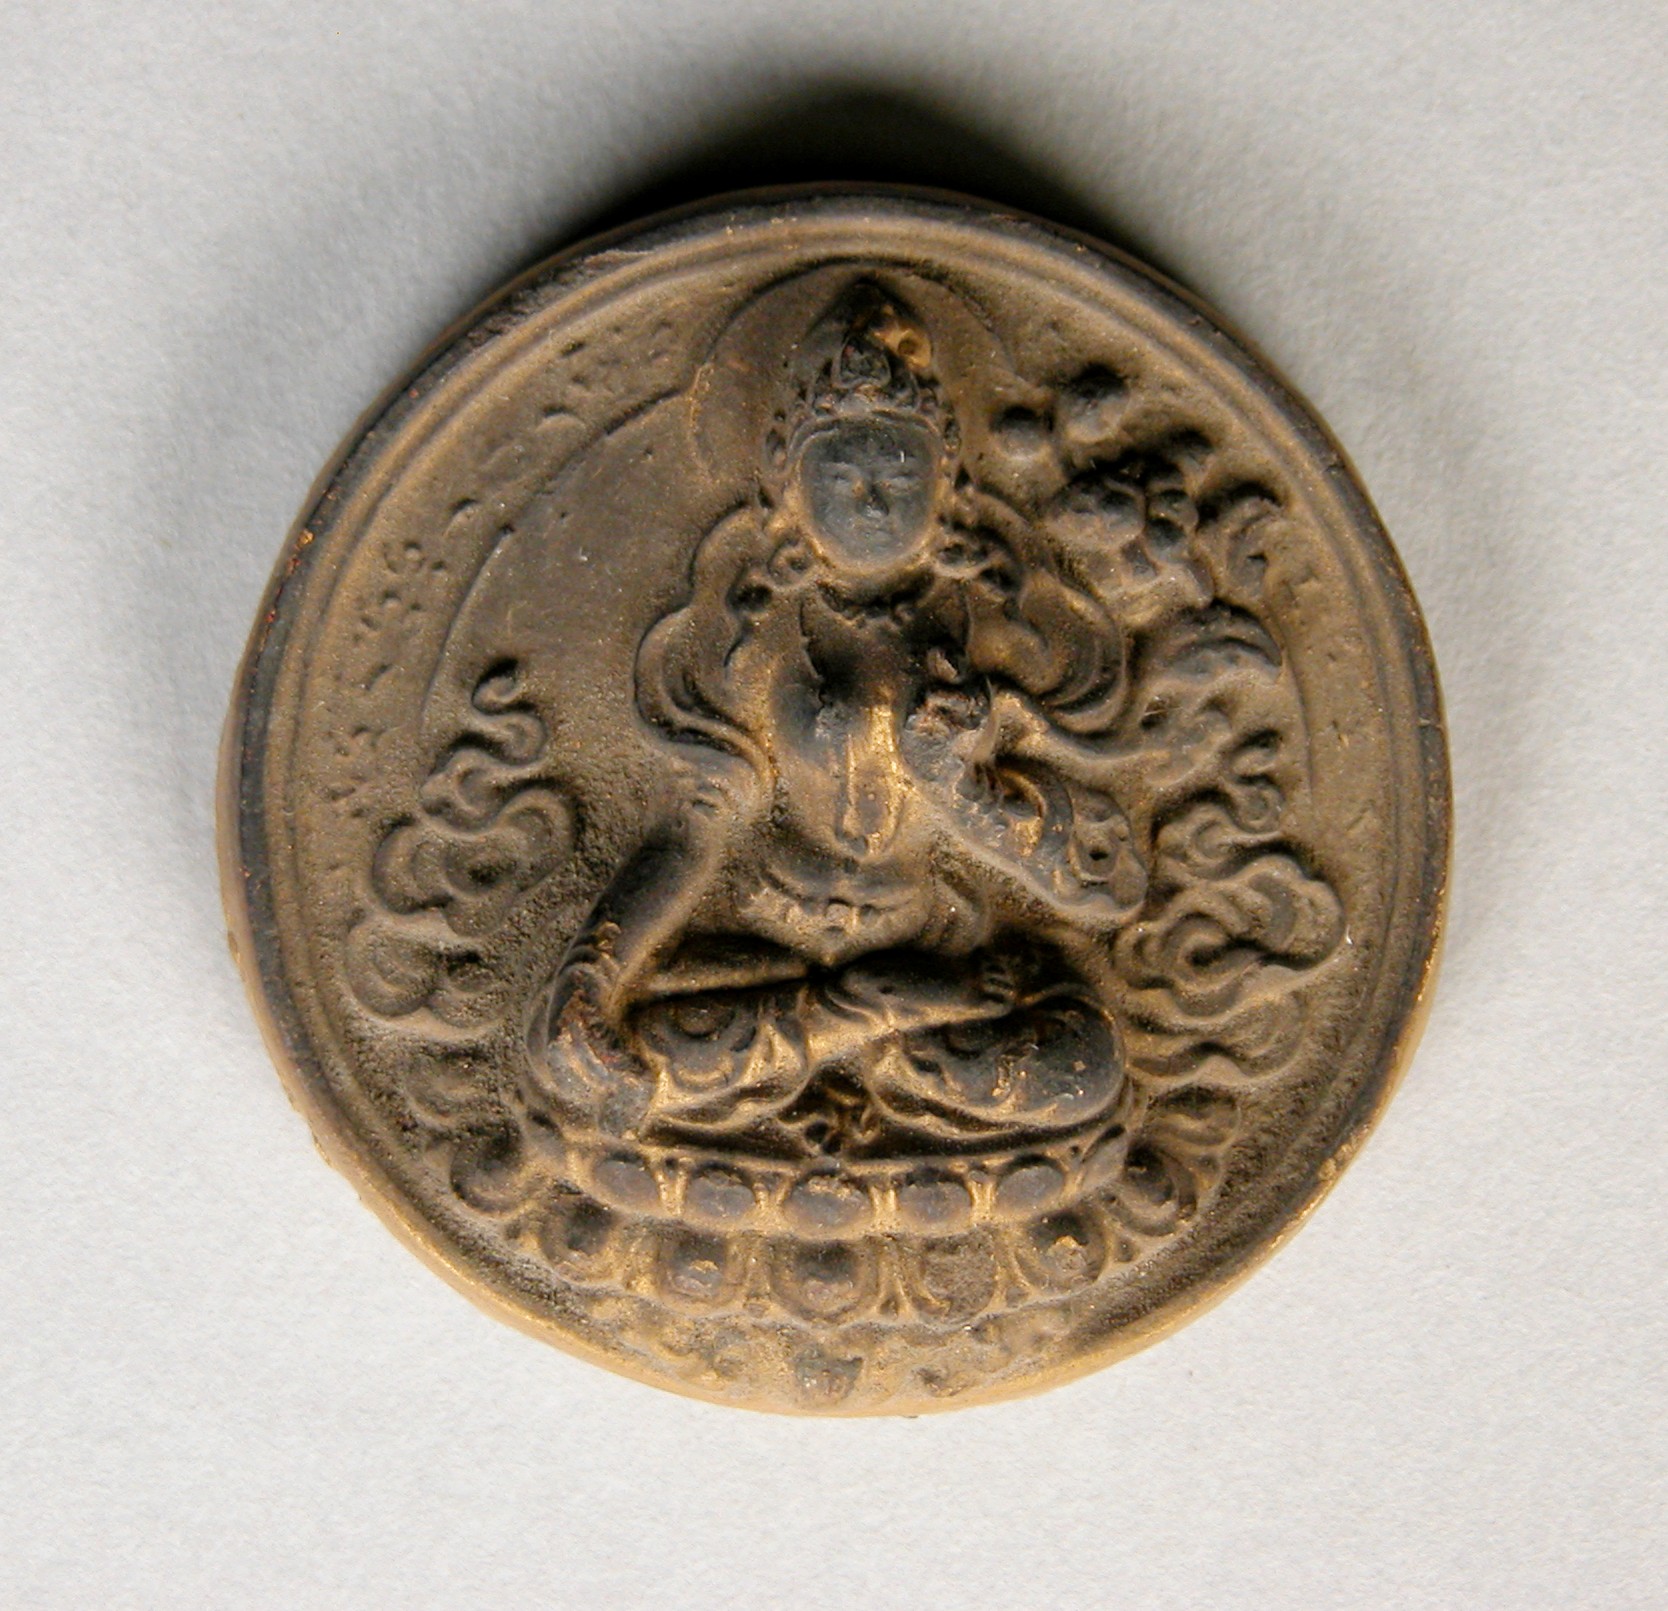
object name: plaque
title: Votive Plaque with White Taras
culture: tibetan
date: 1368-1643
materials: clay